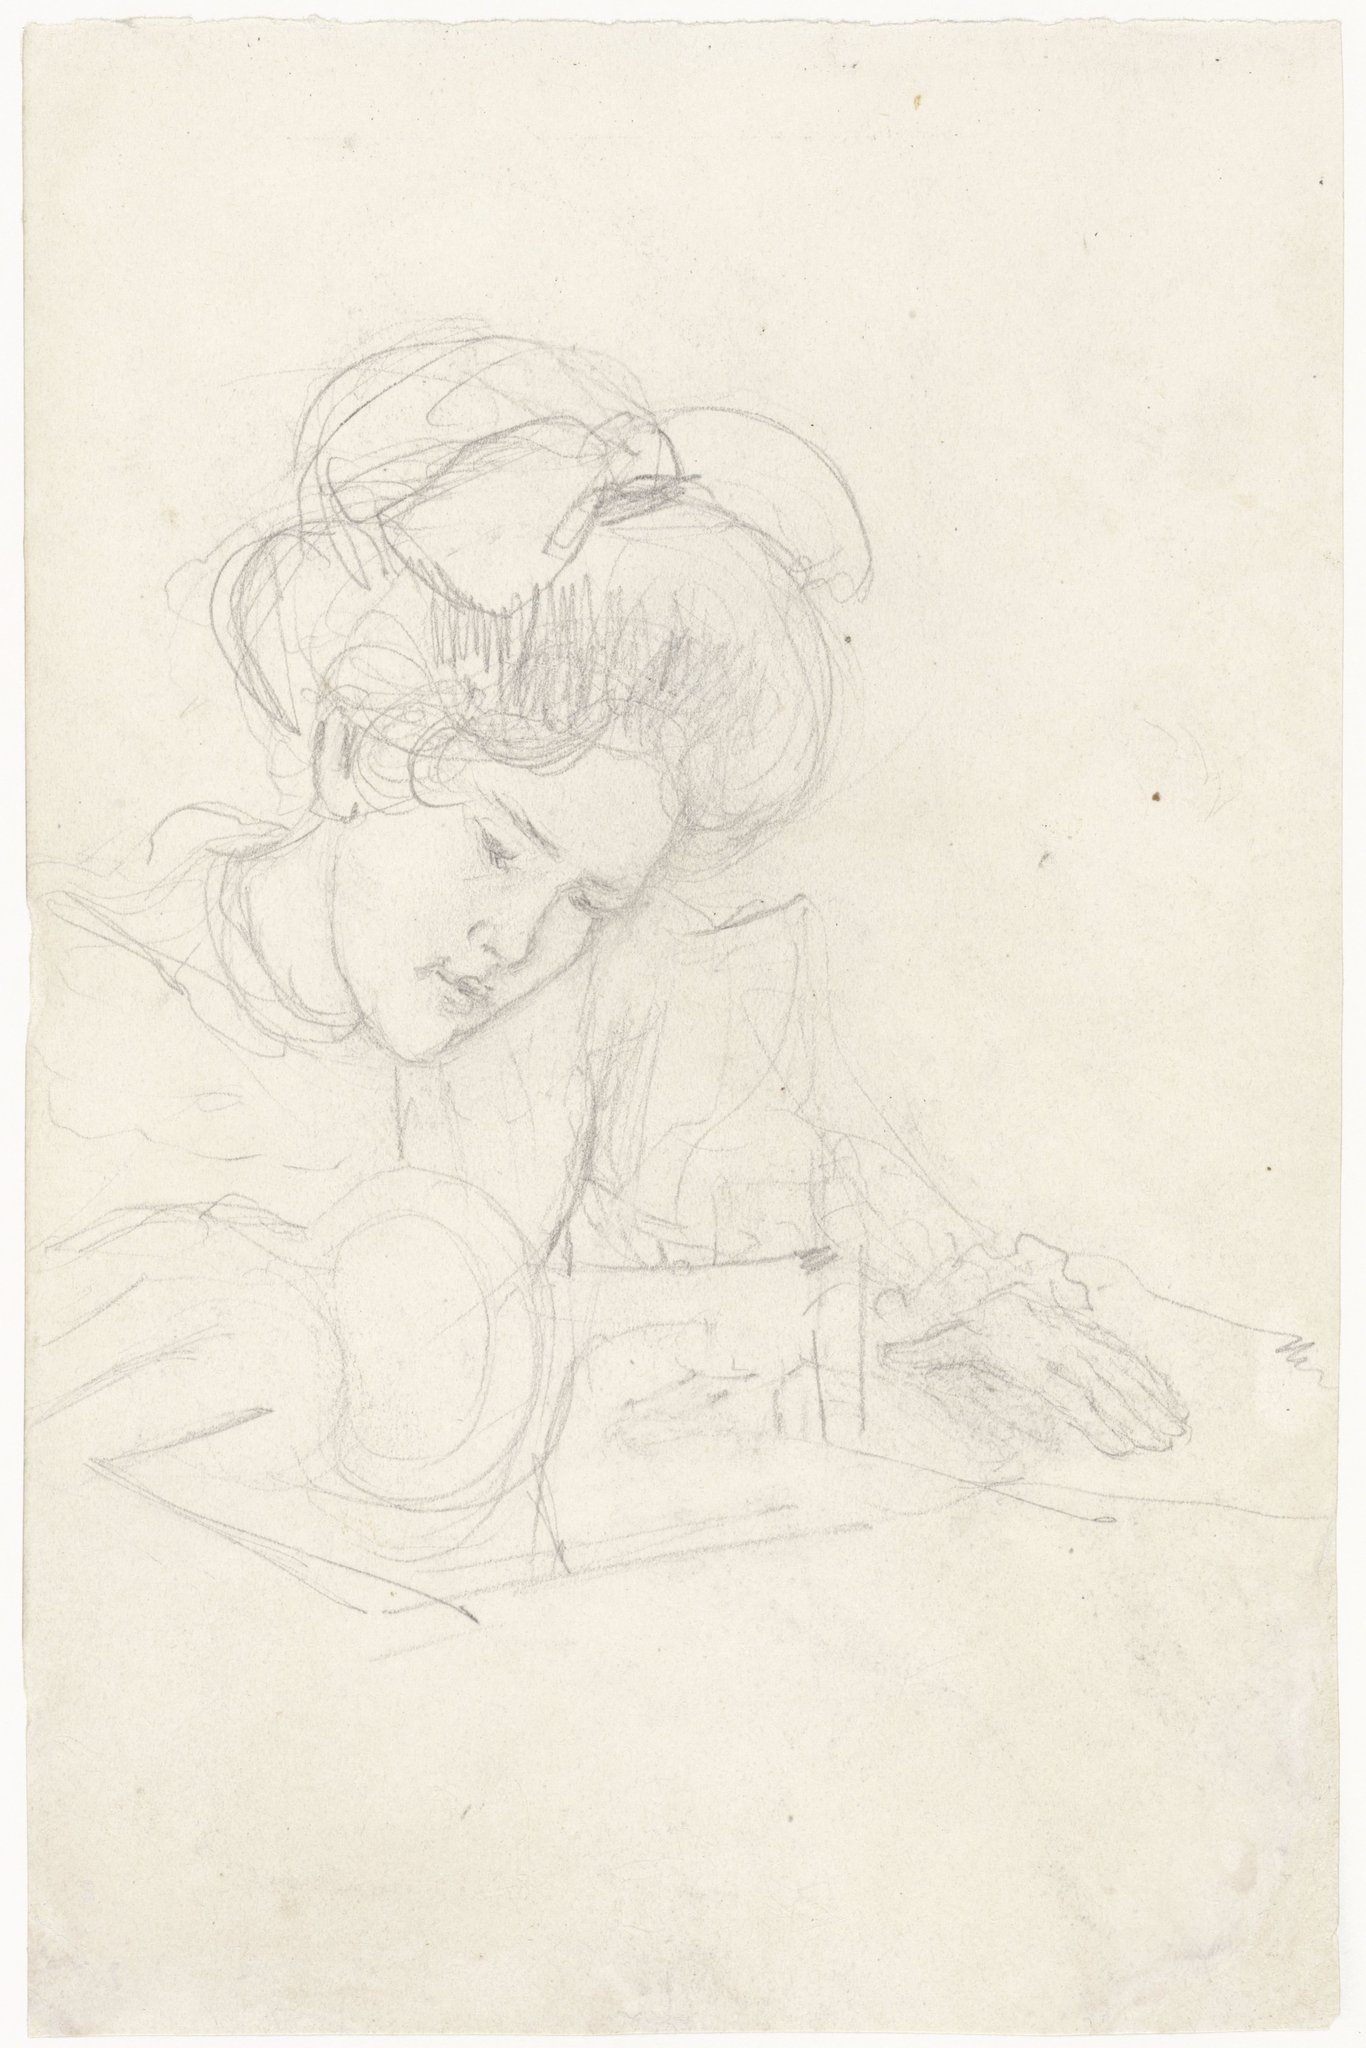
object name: drawing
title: Vrouw achter een naaimachine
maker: jozef israëls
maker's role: draughtsman, painter, print maker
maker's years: 1824-1911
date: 1834-1911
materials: paper, pencil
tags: sewing machine